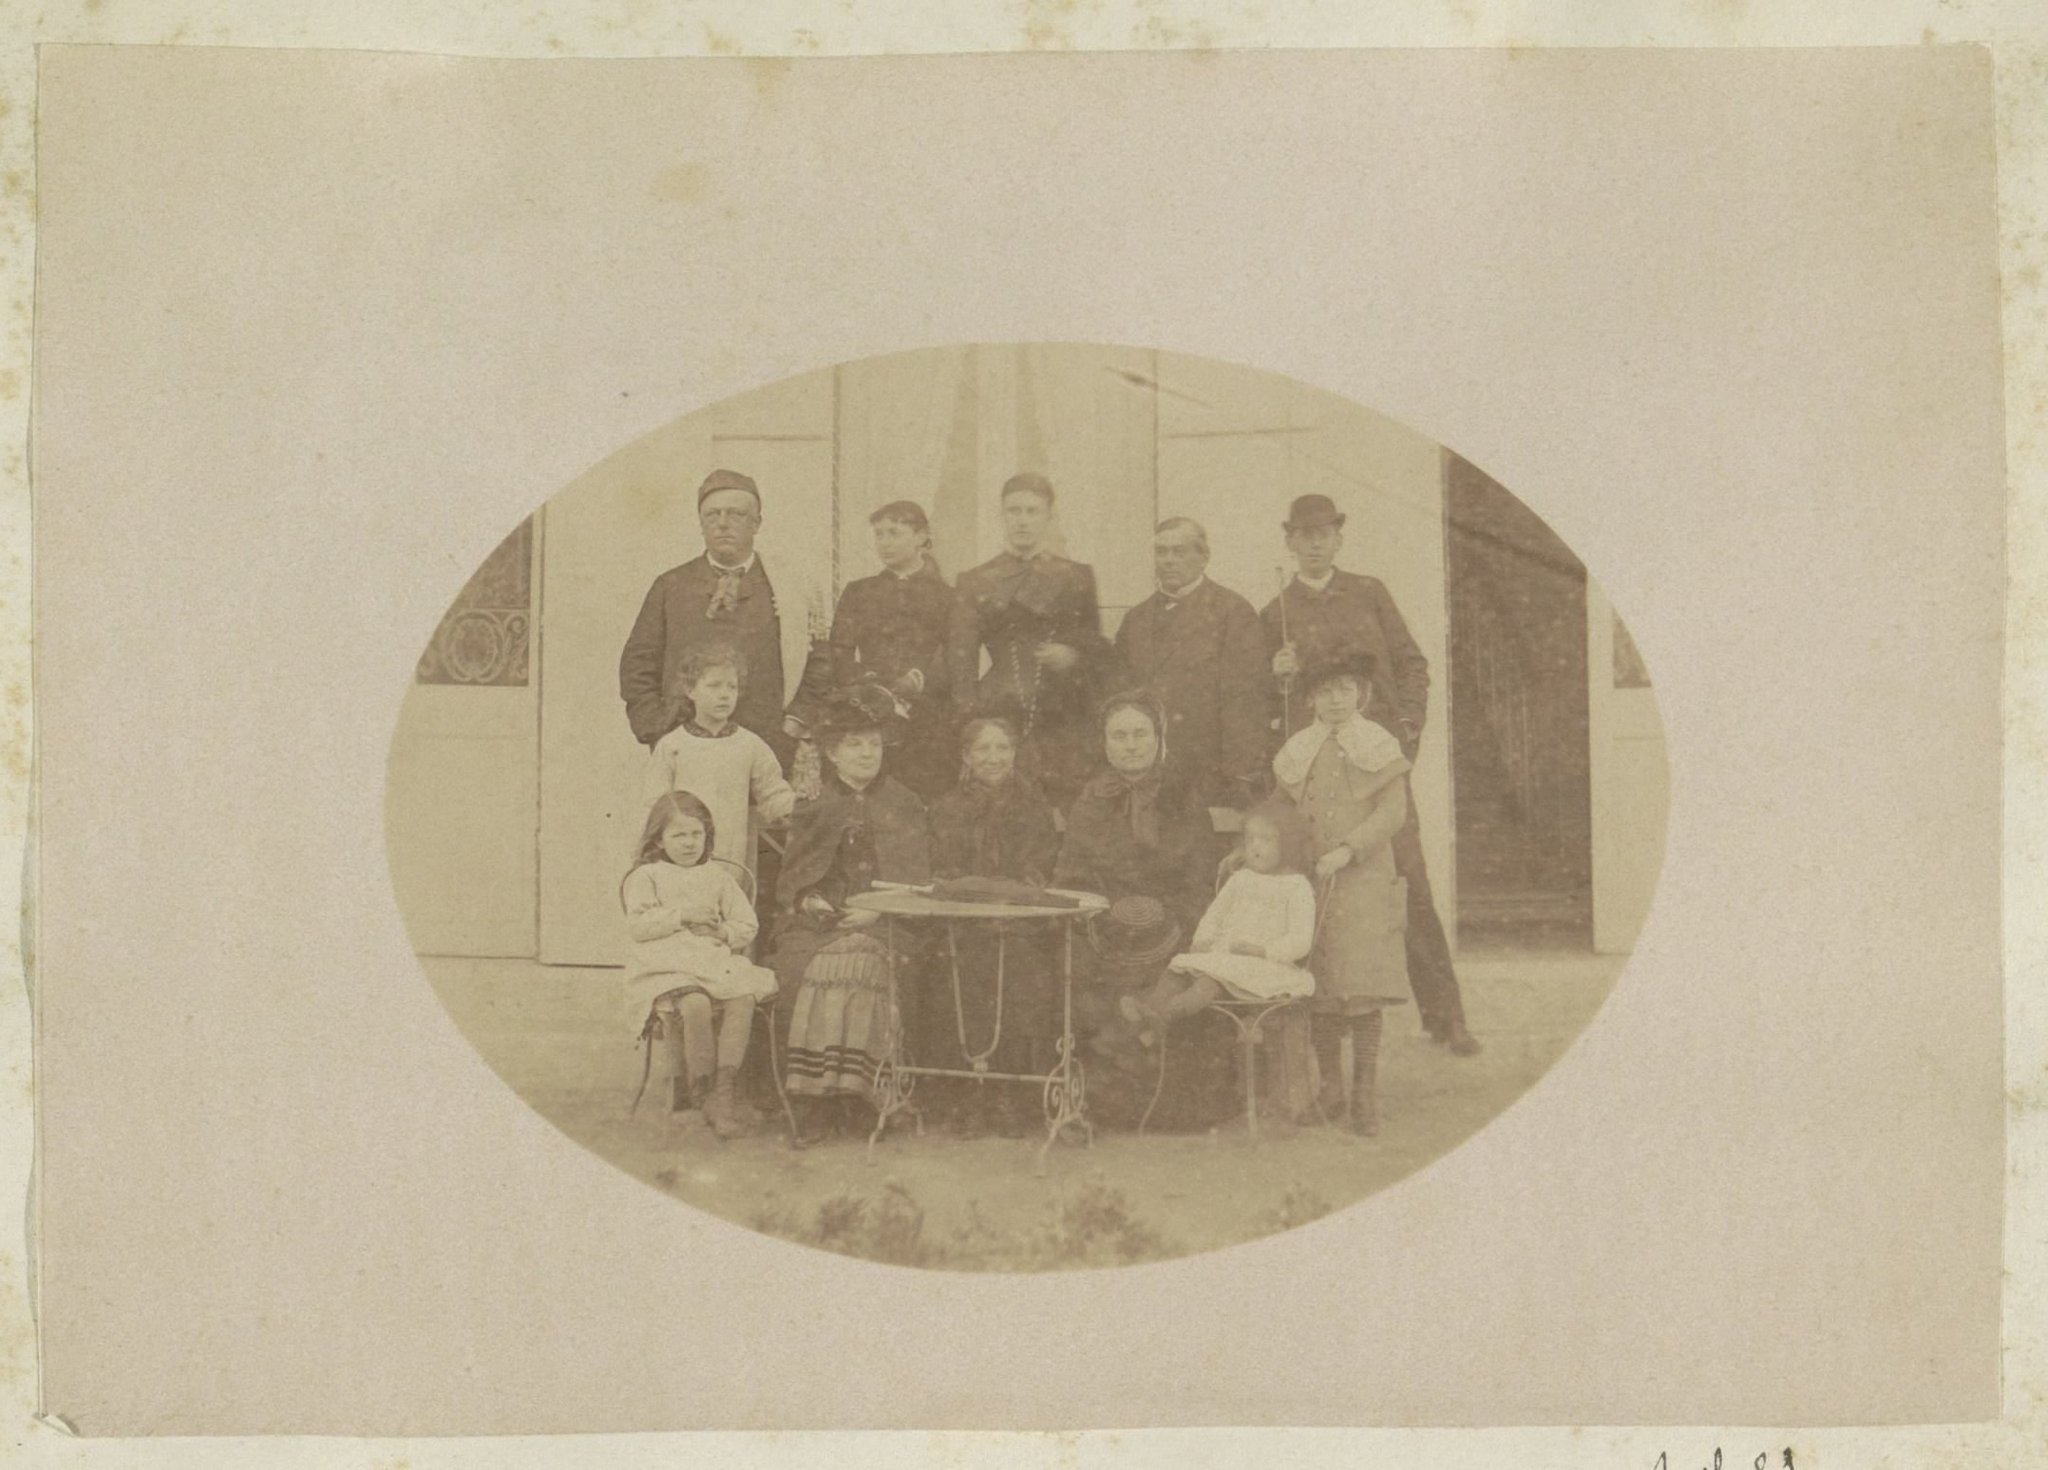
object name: photograph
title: Groepsportret van drie mannen, vijf vrouwen en vier kinderen staand bij een tafel in Frankrijk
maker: Anonymous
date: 1804-1883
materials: photographic support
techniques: albumen print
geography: france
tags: family group, especially parents with their child(ren)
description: Onderdeel van Album van een Franse amateurfotograaf met opnames van familie, militairen, industrie, landschappen en bezienswaardigheden in Frankrijk.